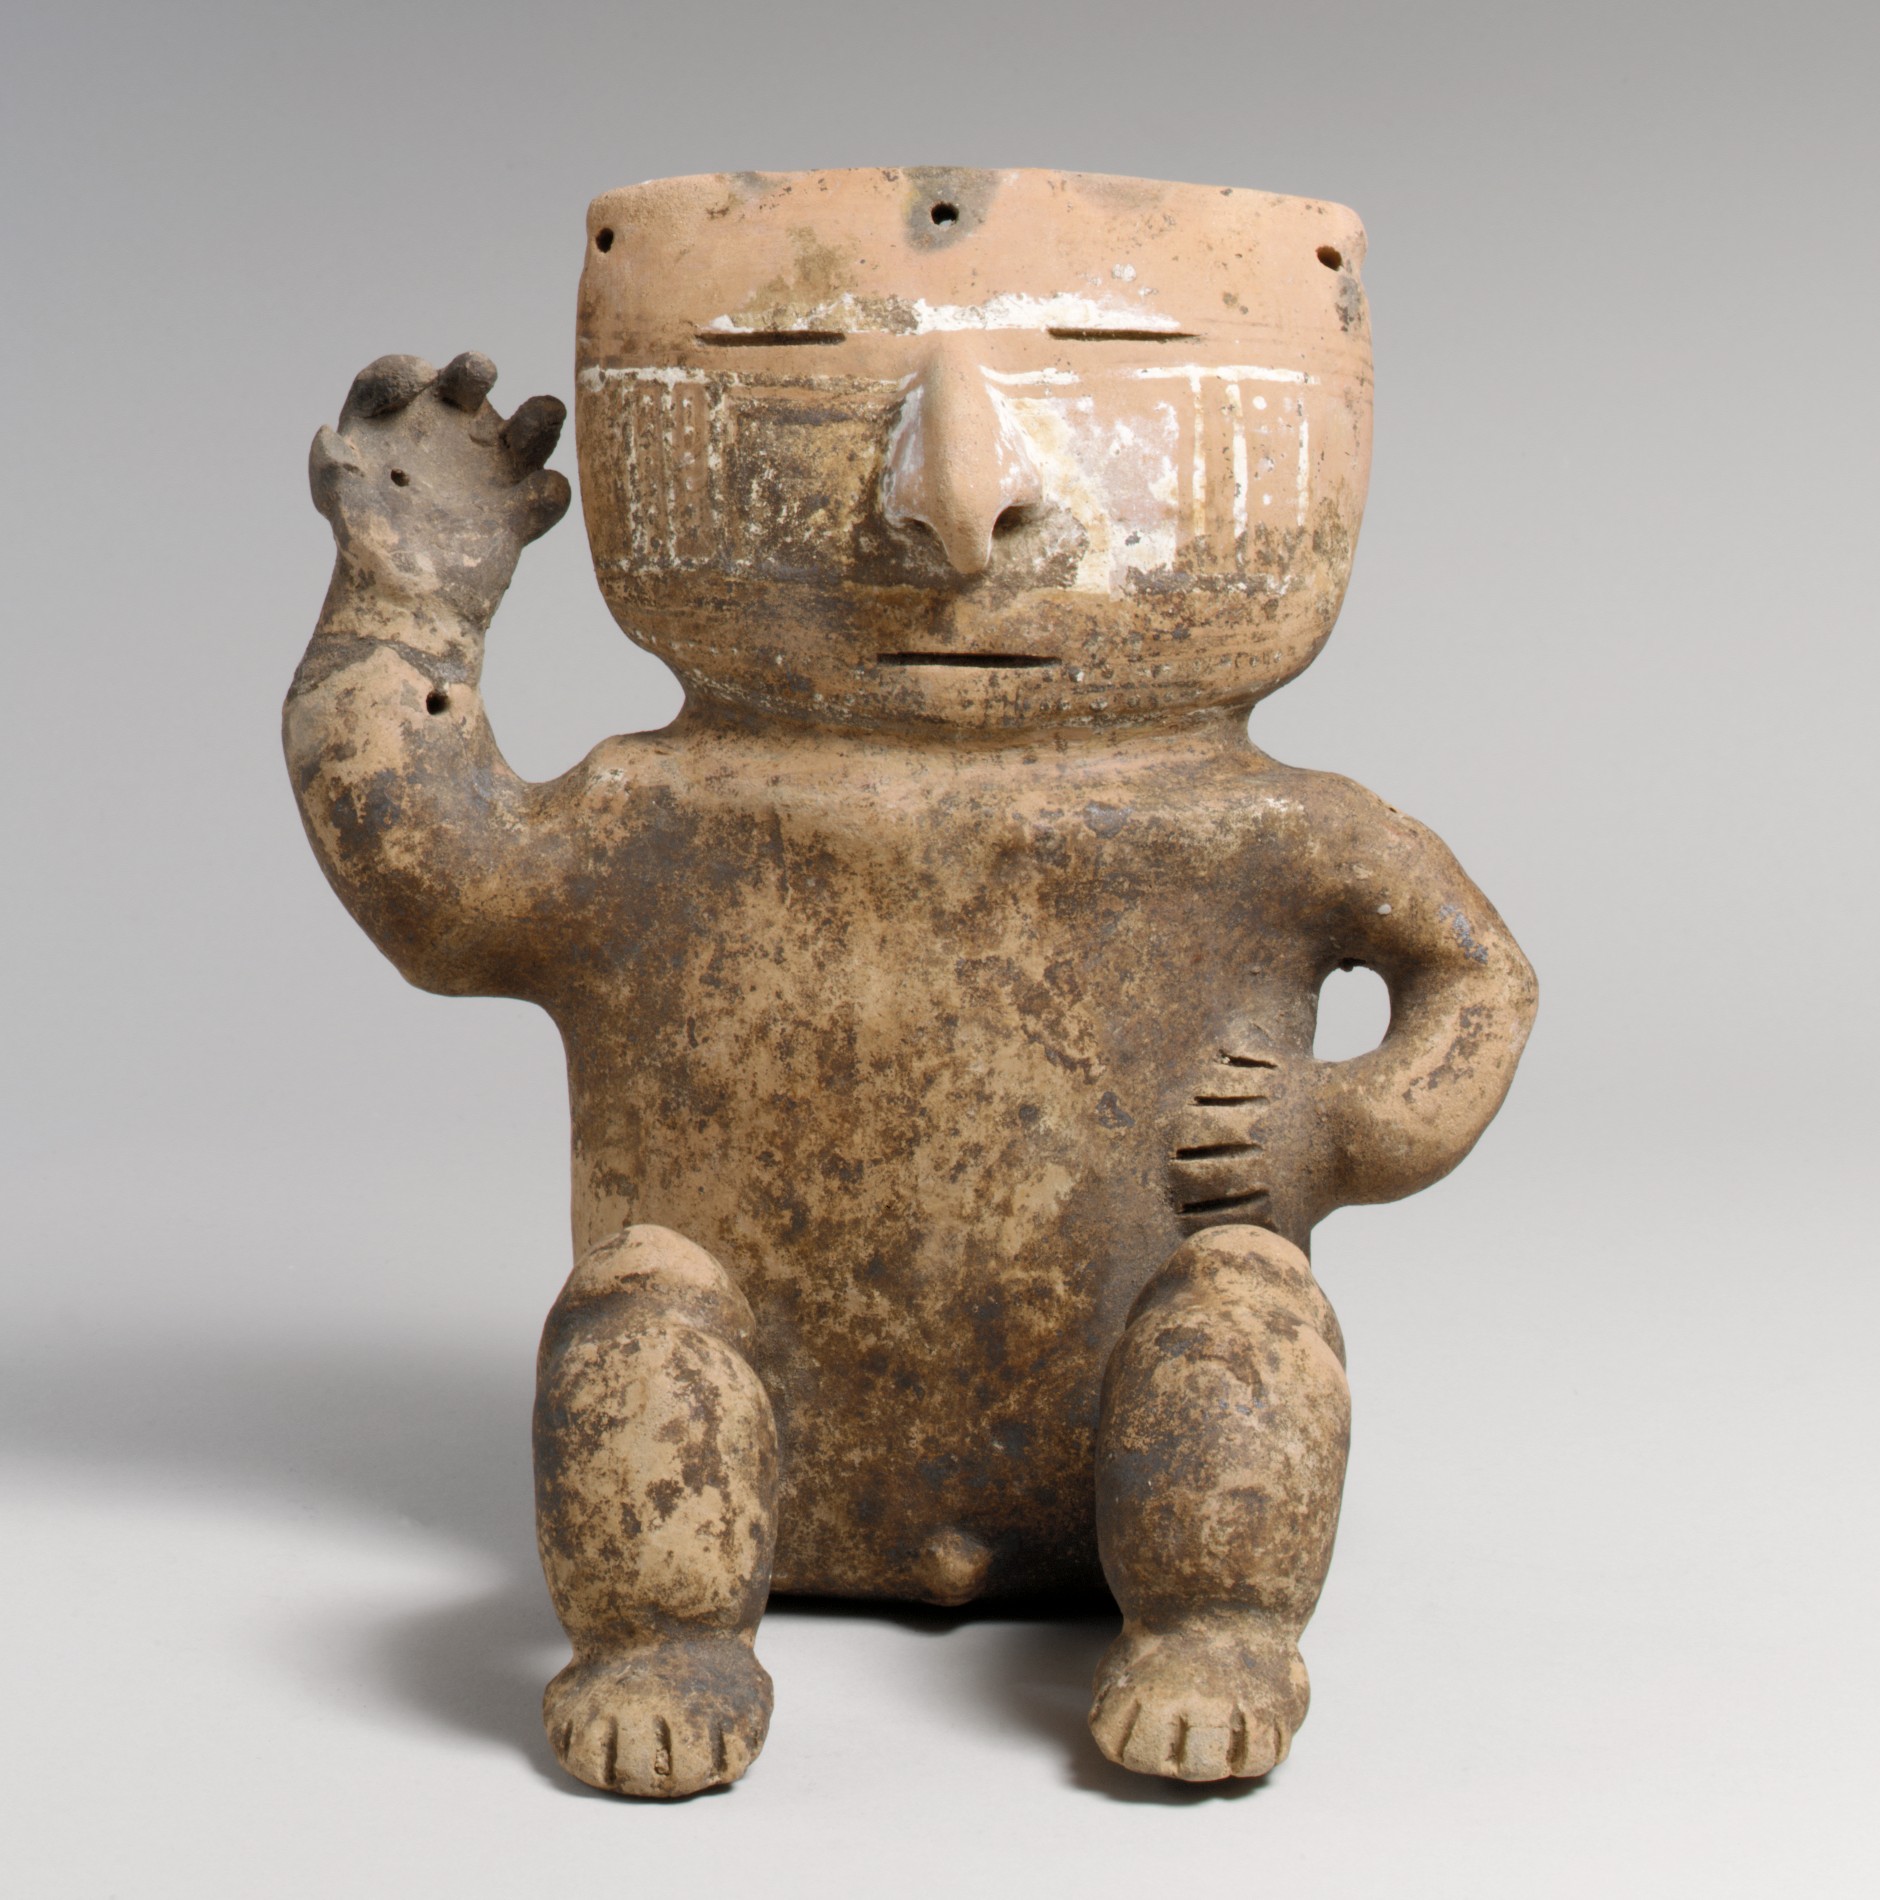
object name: figure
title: Seated Figure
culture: quimbaya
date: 1201-1500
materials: ceramic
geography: colombia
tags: human figures